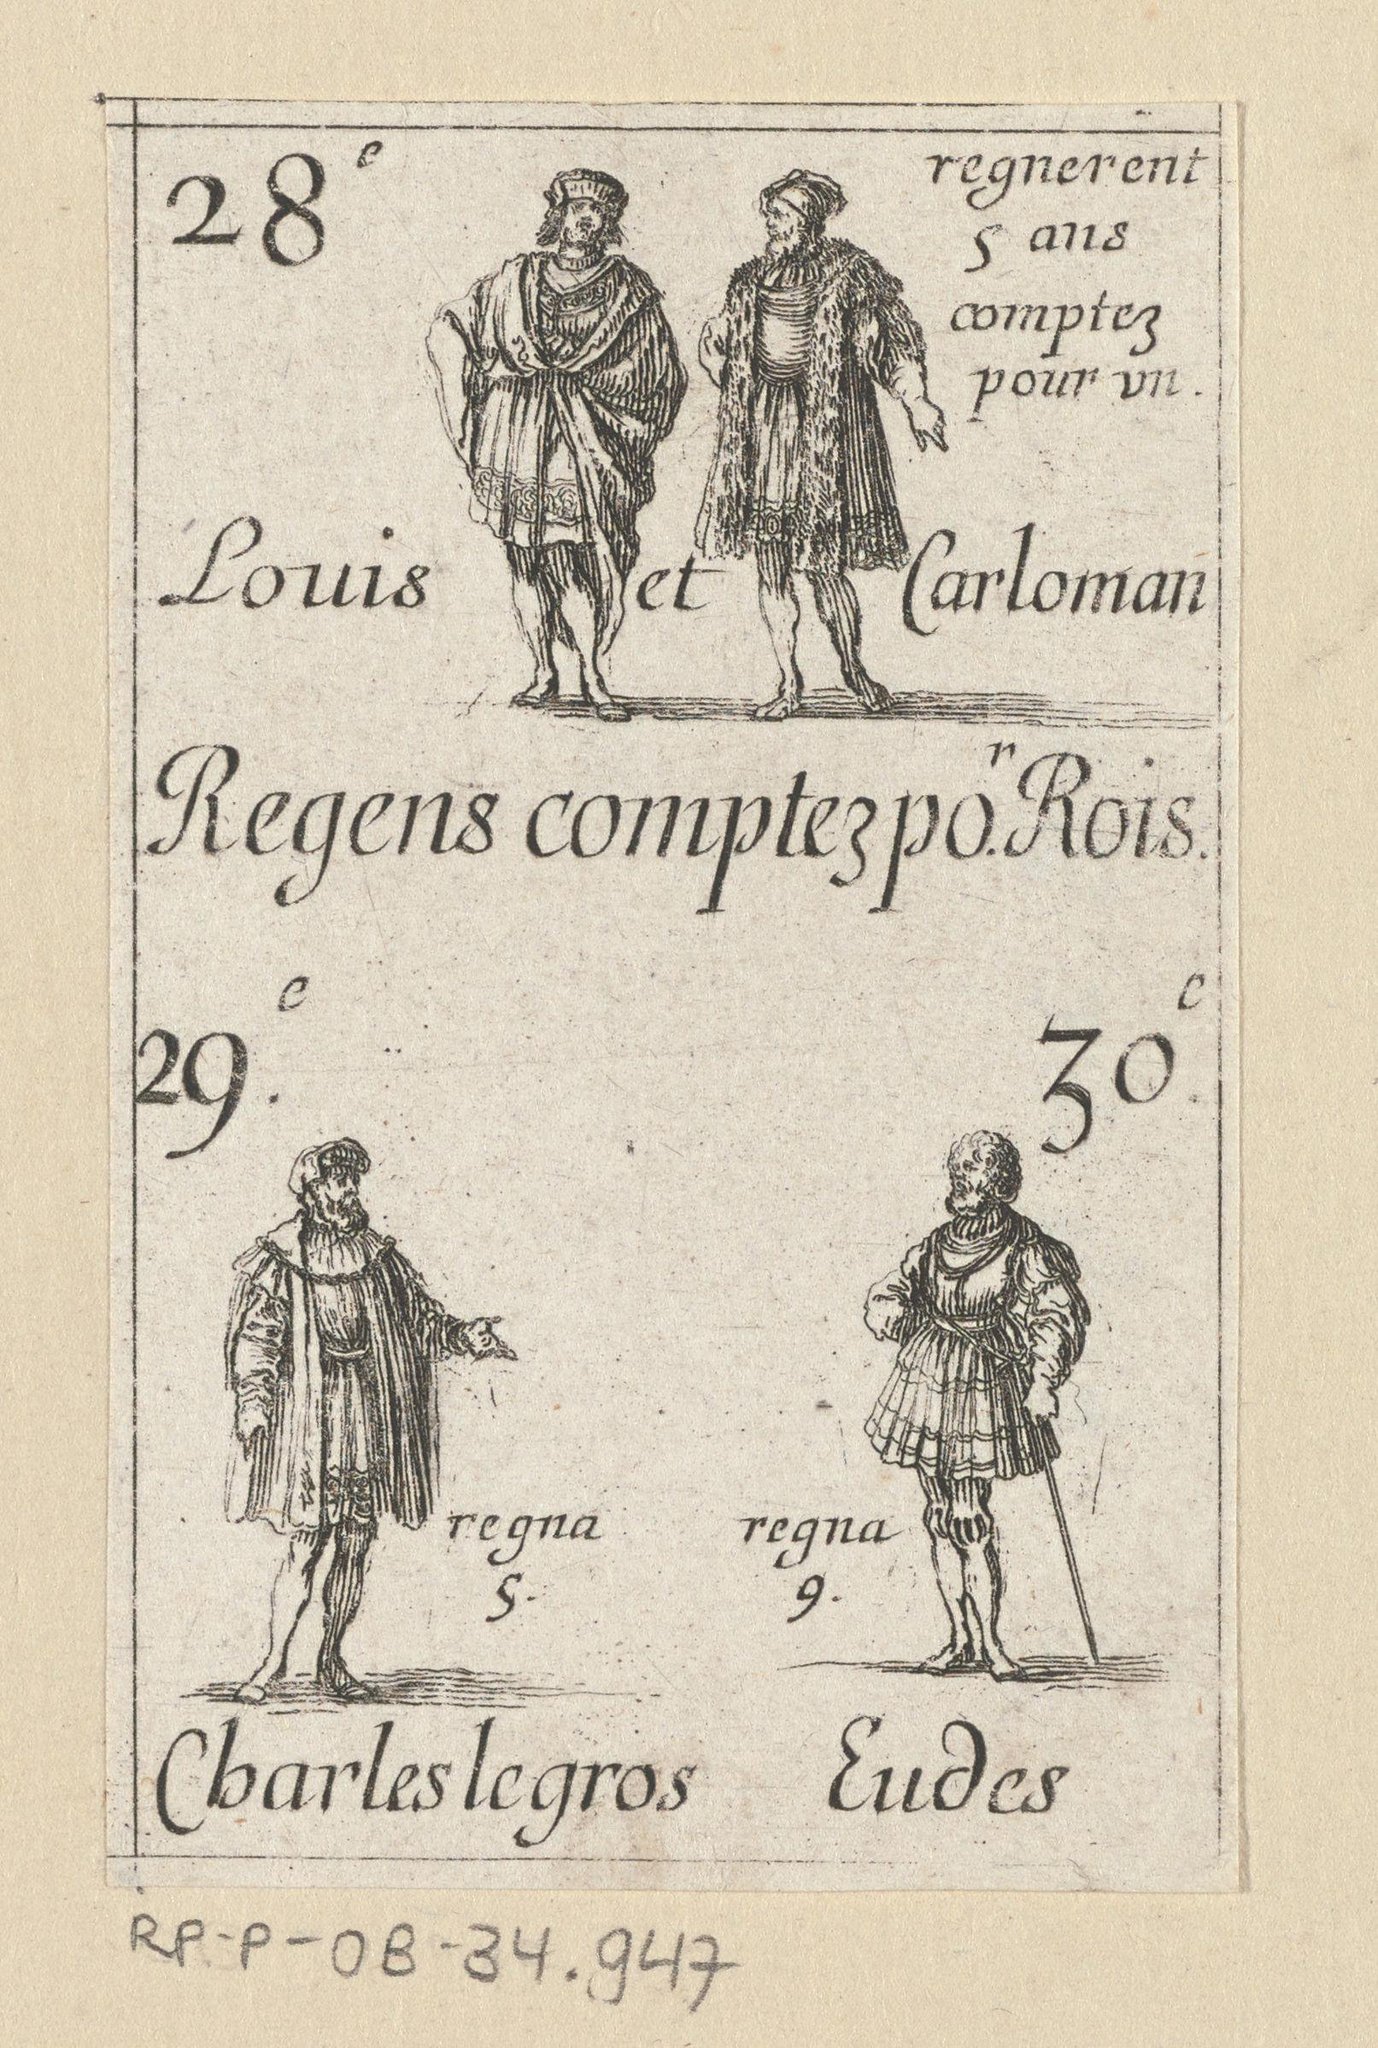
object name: print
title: Lodewijk III, Karloman II, Karel III en Odo I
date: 1620-1664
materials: paper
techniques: etching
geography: paris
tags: ruler, sovereign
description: Deze prent maakt deel uit van een kaartspel met 39 kaarten met voorstellingen van Franse koningen. De serie is uitgedacht door Jean Desmarests de Saint-Sorlin in opdracht van Kardinaal Mazarin. Het kaartspel werd gemaakt voor de jonge Lodewijk XIV, samen met het Jeu des Fables, Jeu des Reynes Renommées en Jeu de la géographie.